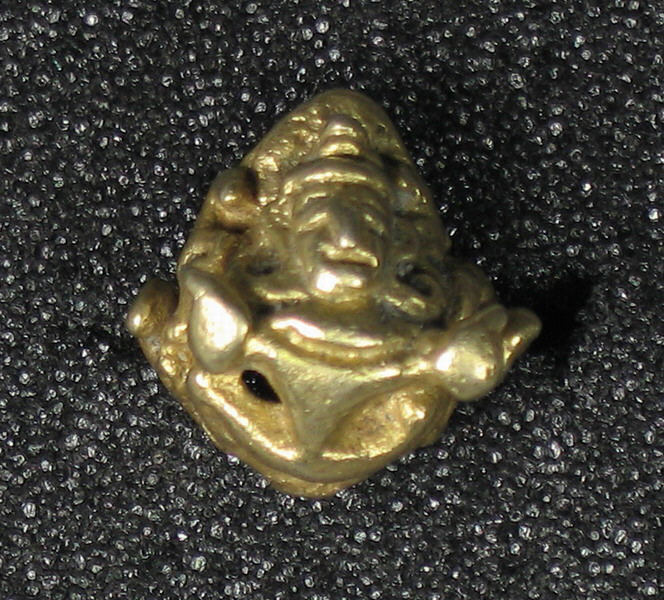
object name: ear ornament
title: Ear ornament, Garuda and Meru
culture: indonesian, central java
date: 701-1200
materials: gold